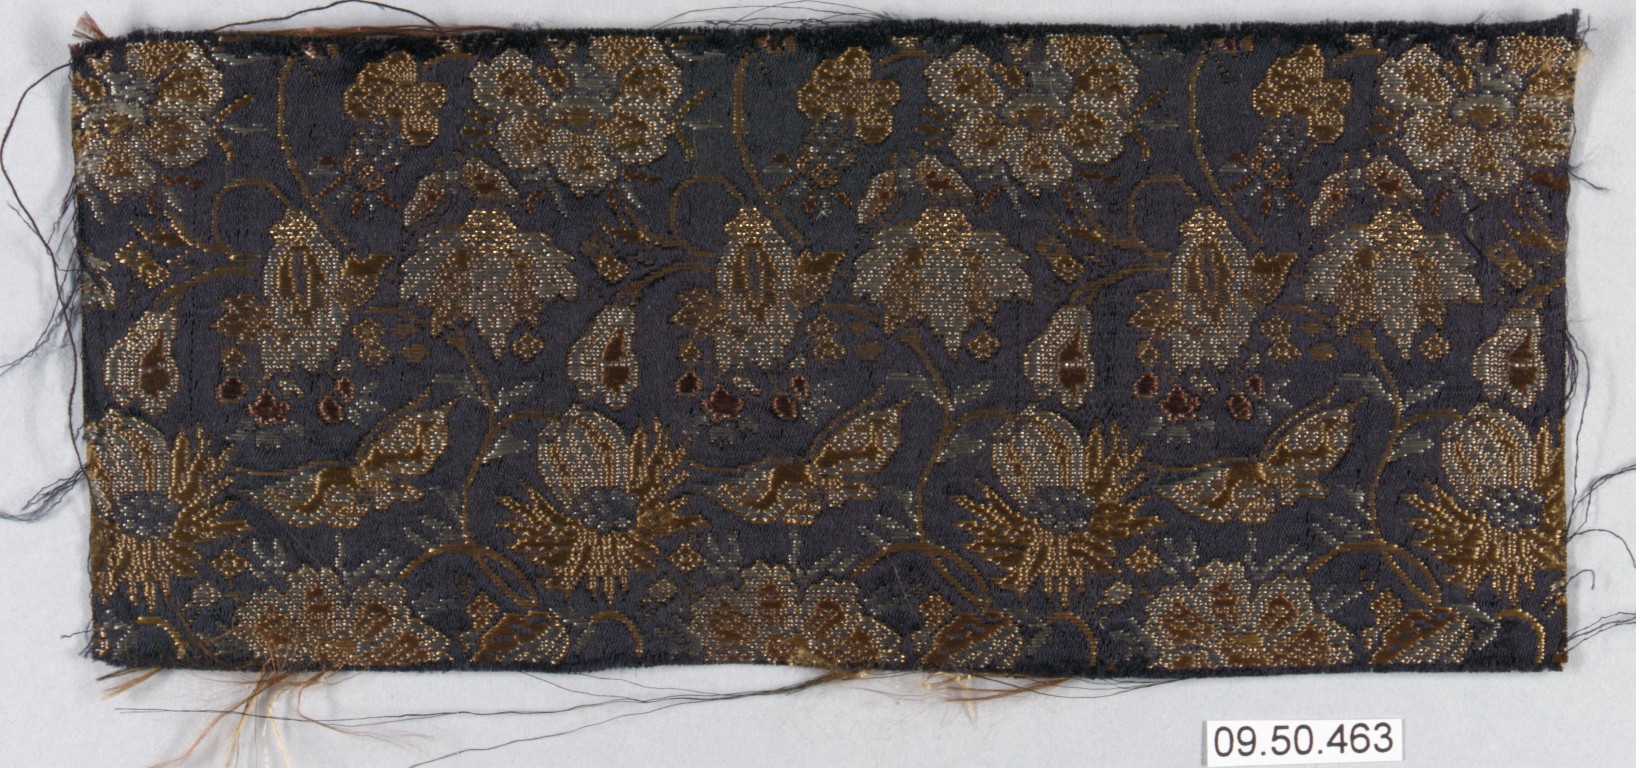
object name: piece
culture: japanese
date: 1801-1900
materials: metal thread, silk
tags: butterflies